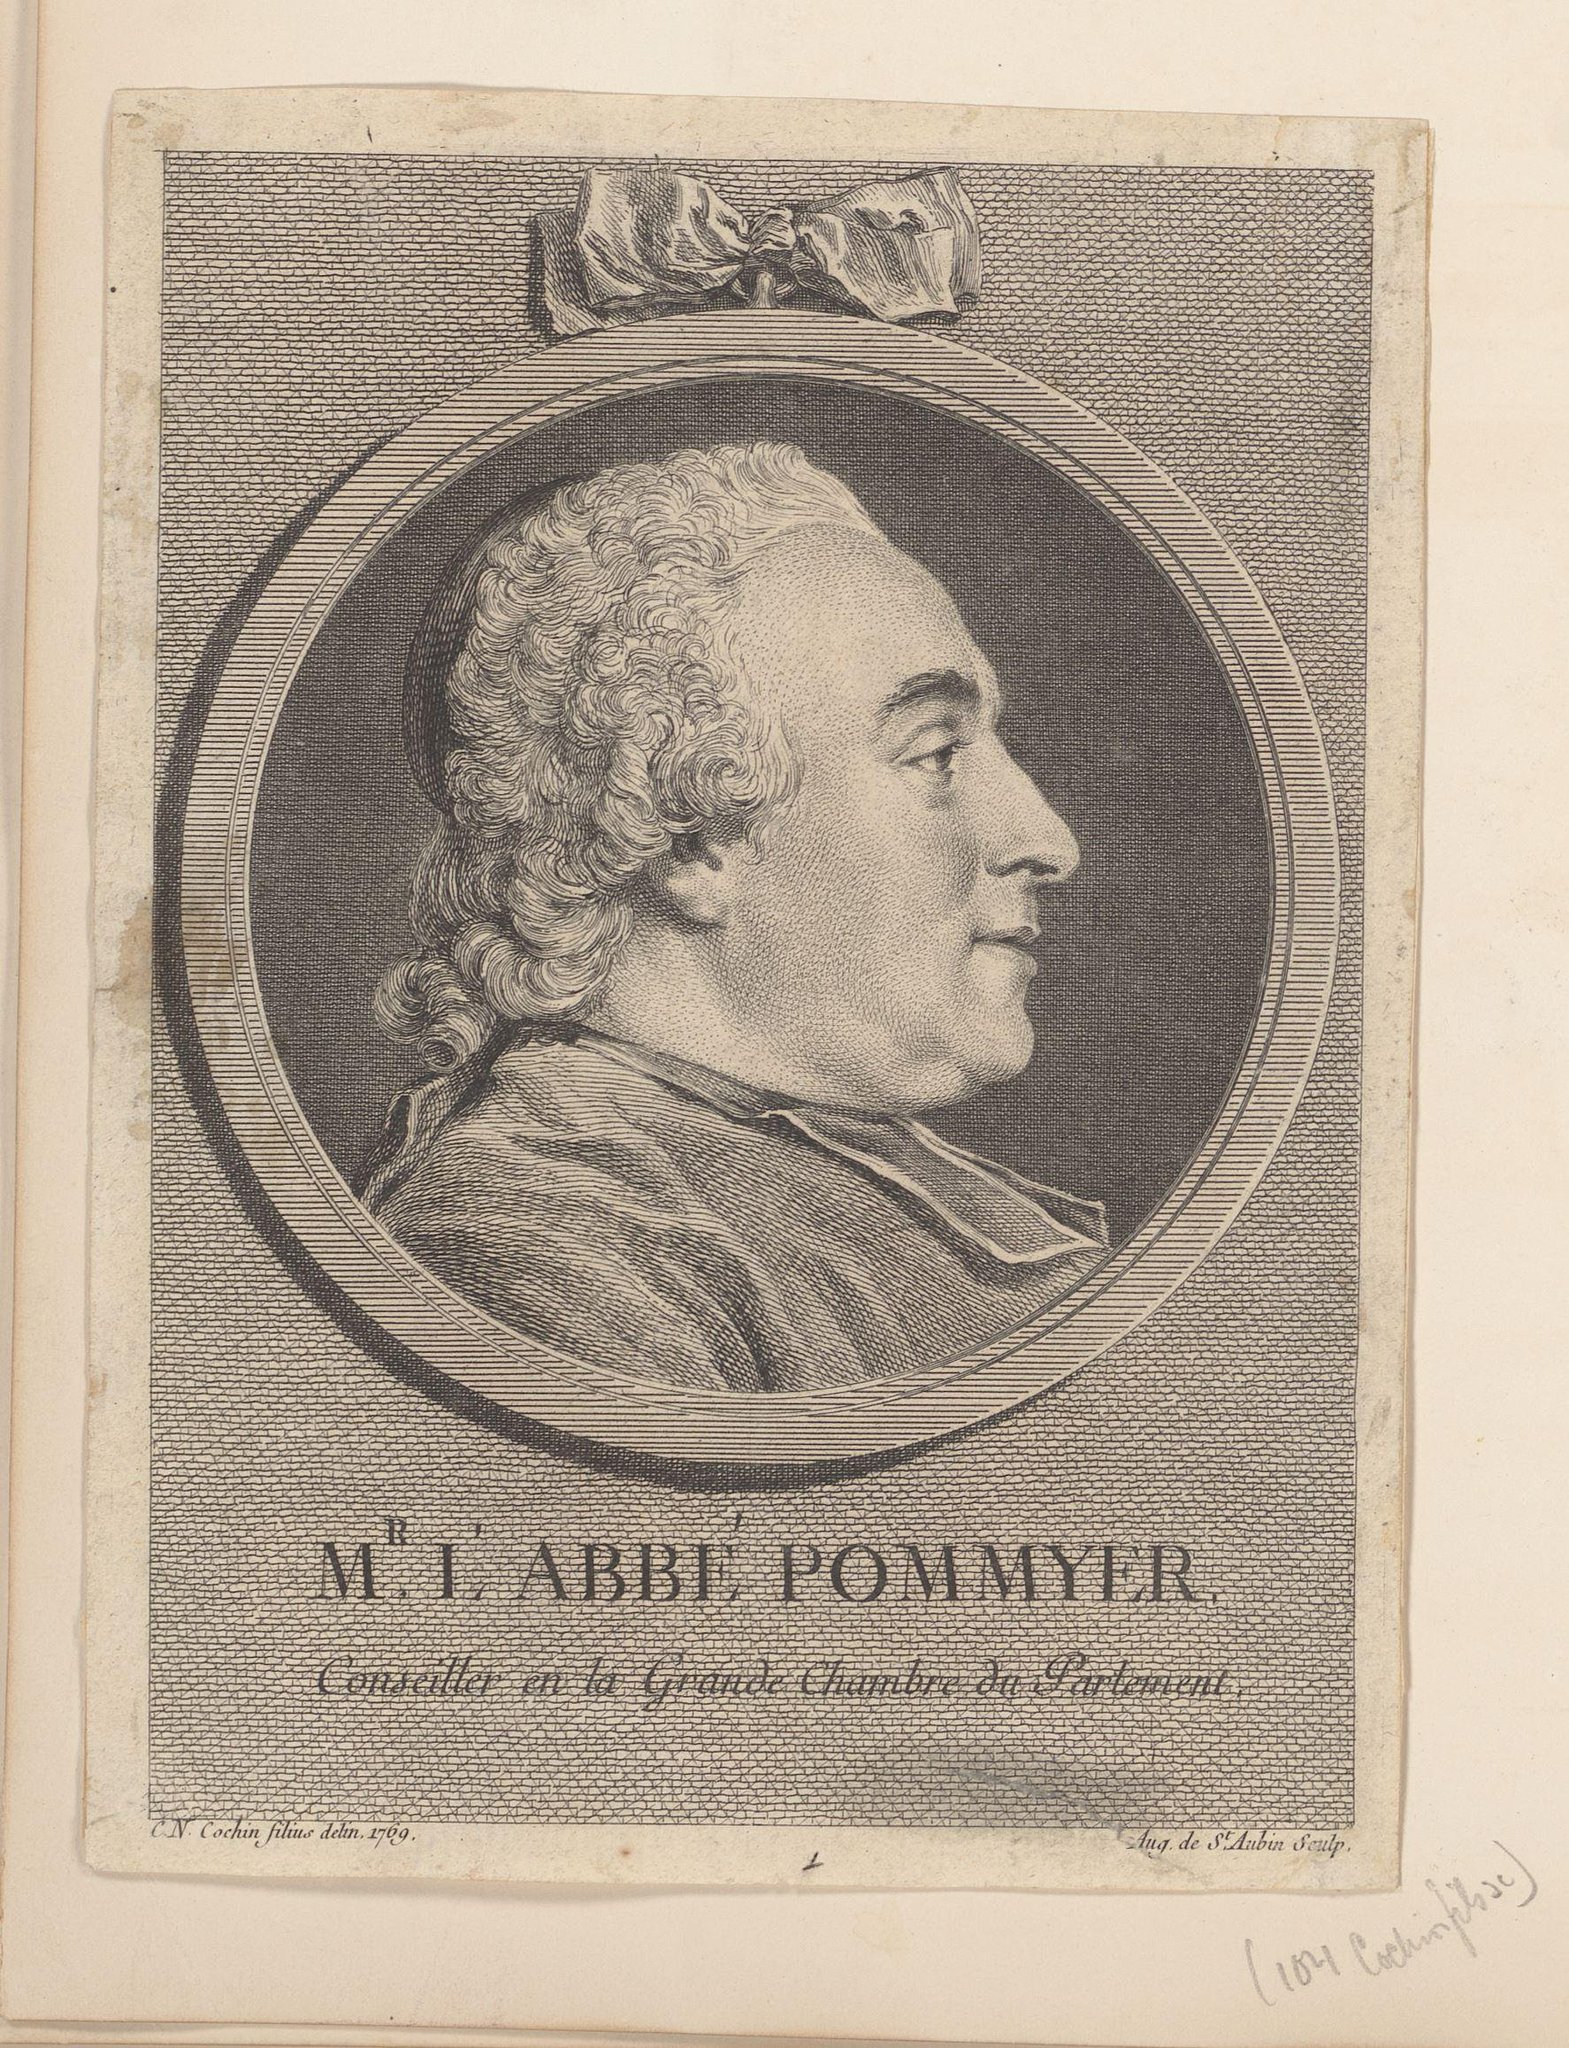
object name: print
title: Portret van François Emmanuel Pommyer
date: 1769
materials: paper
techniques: engraving, etching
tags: historical persons, organization, functionaries and dignitaries in roman catholic church; clergy in general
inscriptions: date